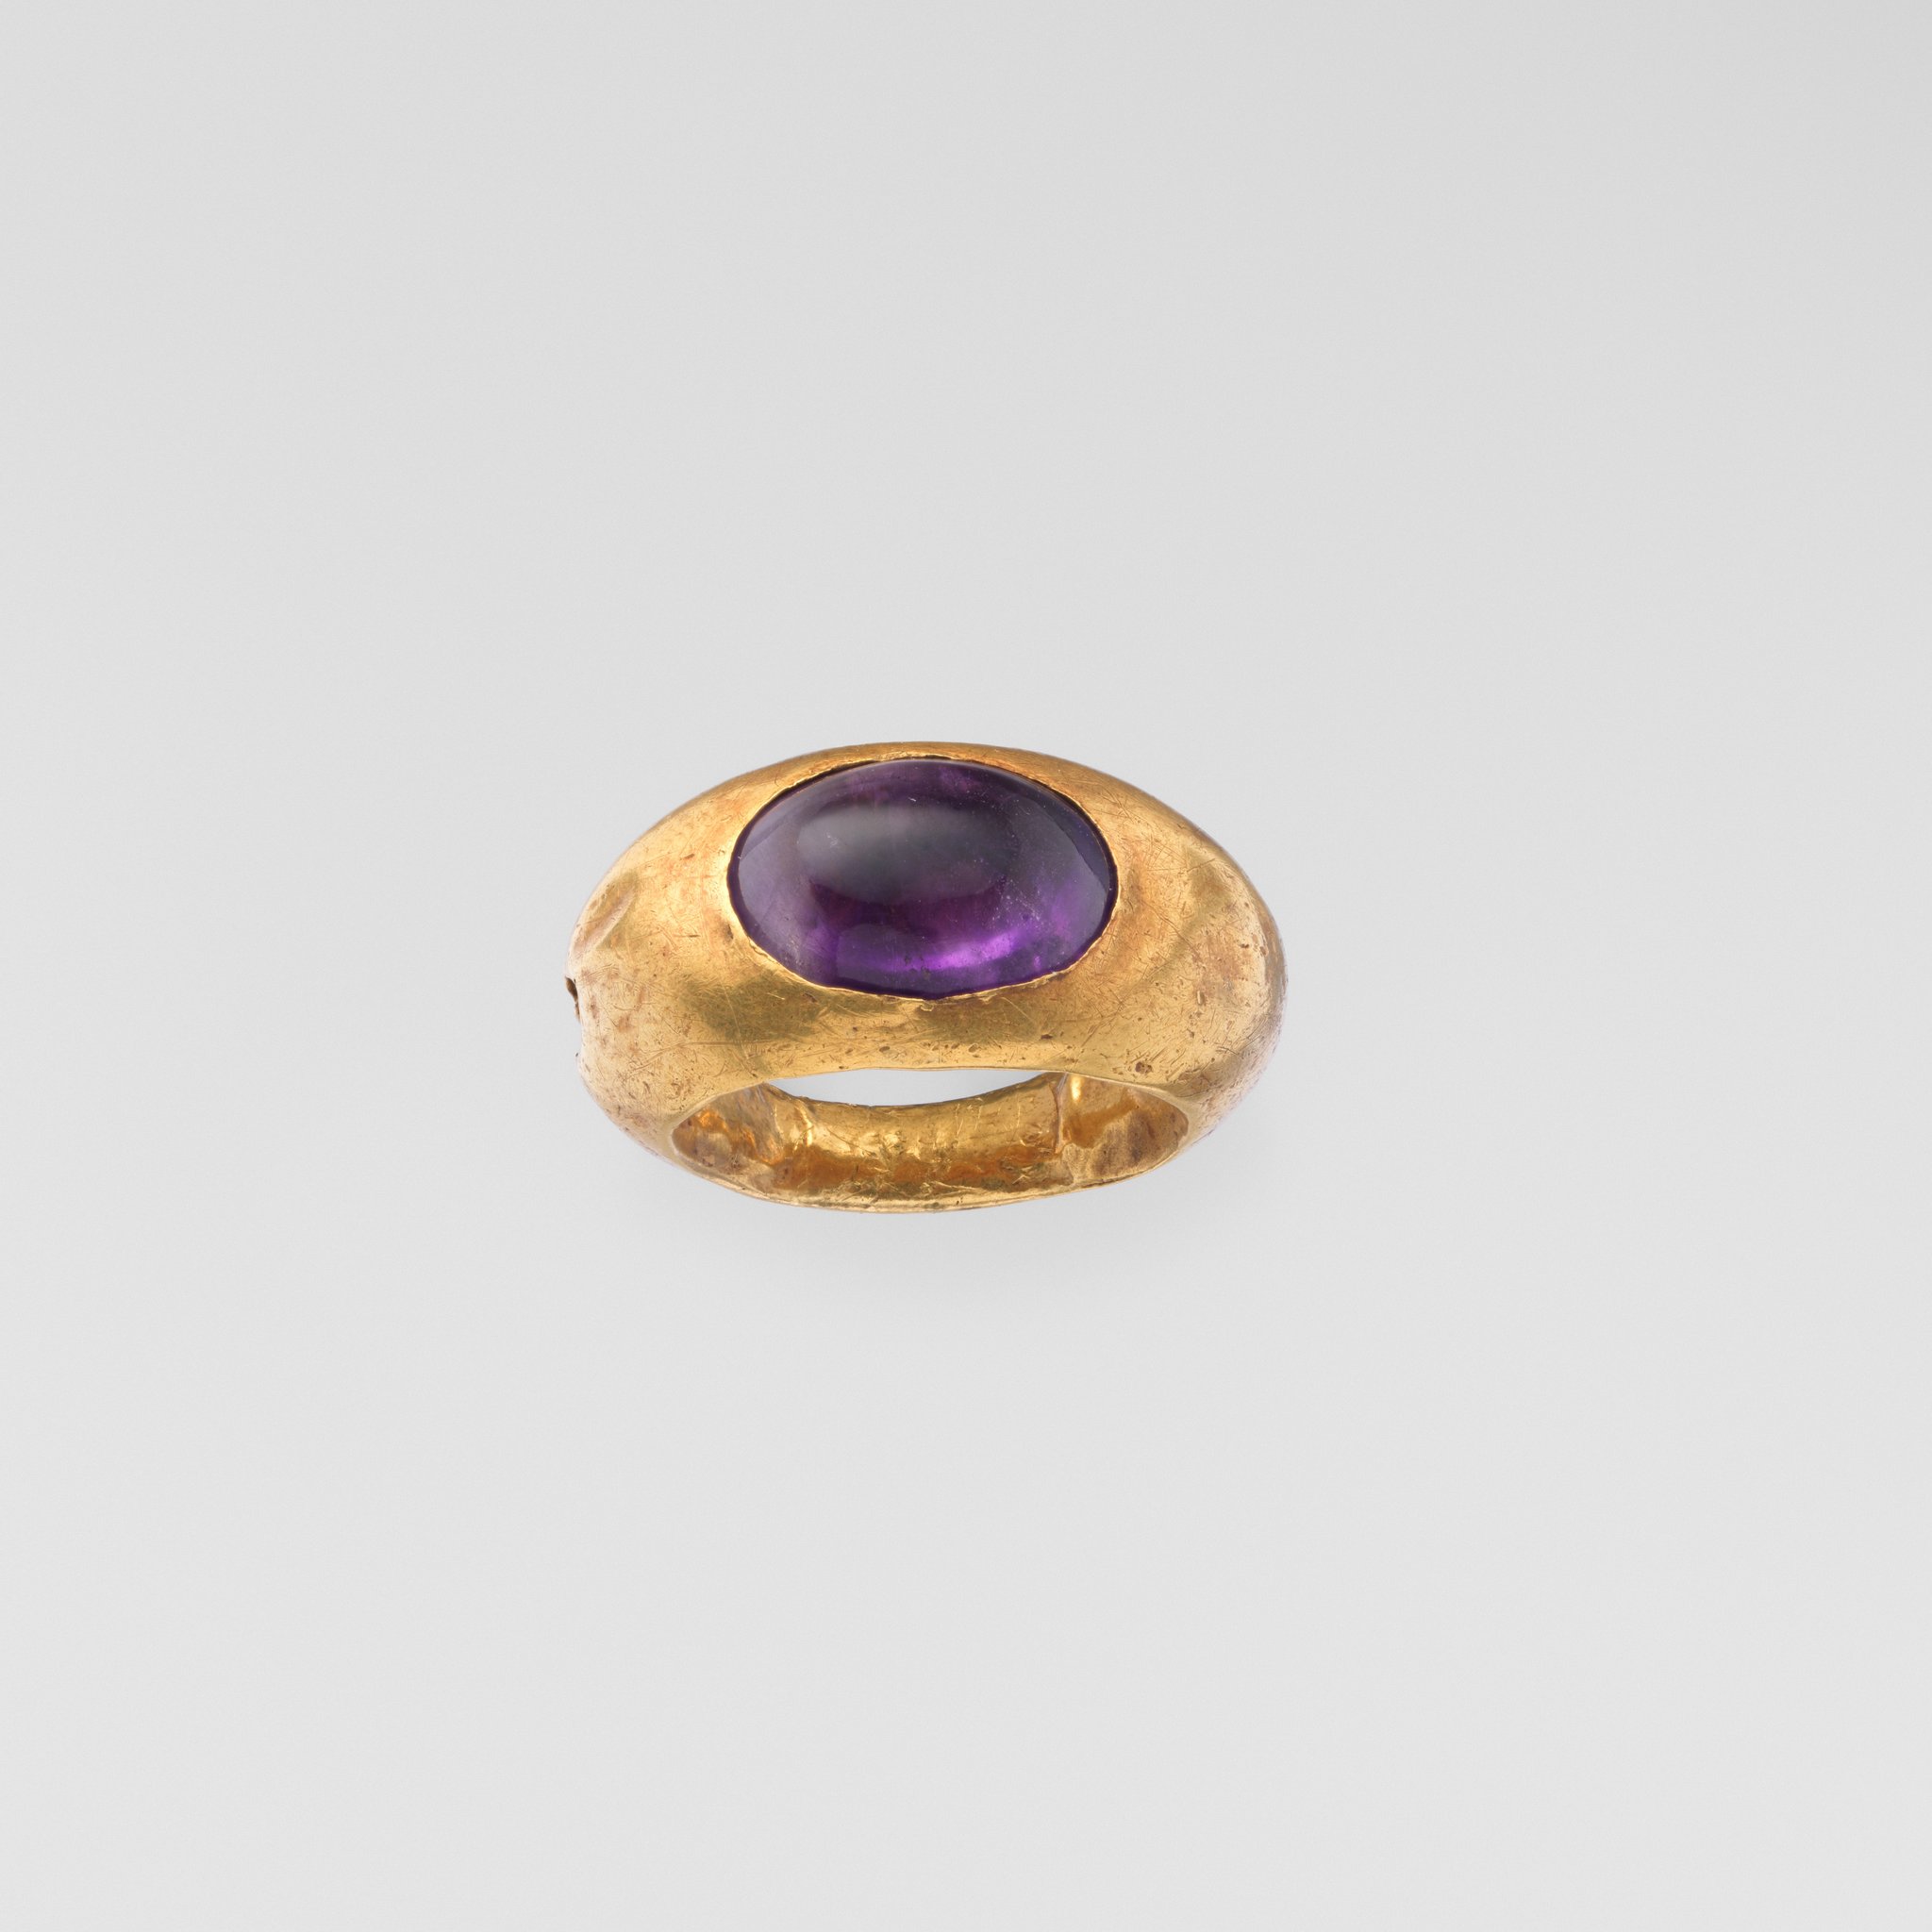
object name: ring with amethyst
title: Gold and amethyst ring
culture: roman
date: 1-100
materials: gemstone, gold